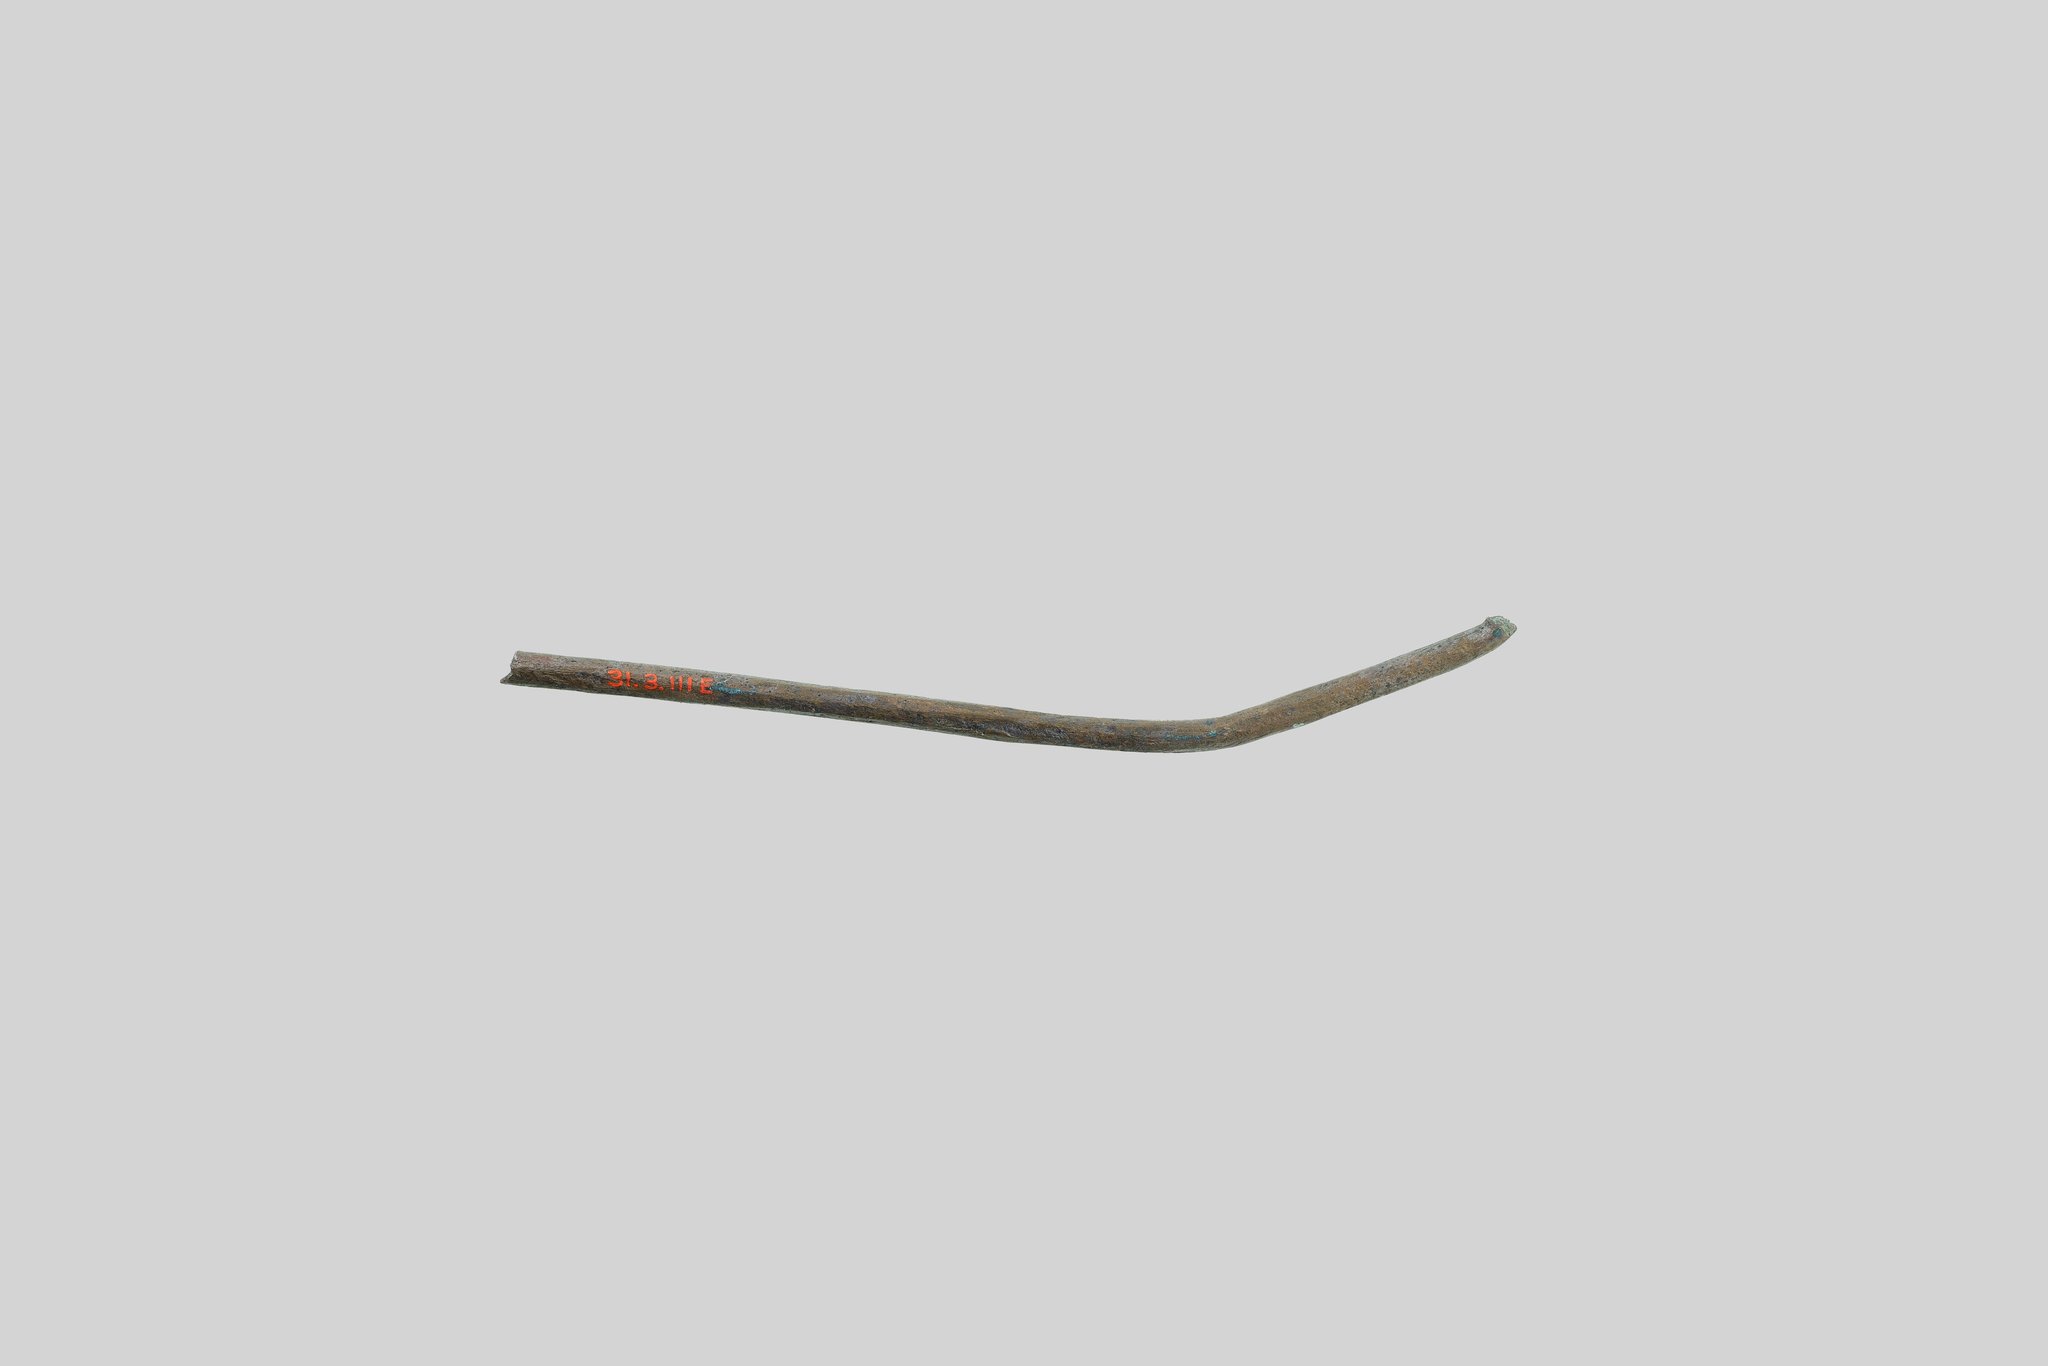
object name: rod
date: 664-332 BCE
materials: copper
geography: egypt